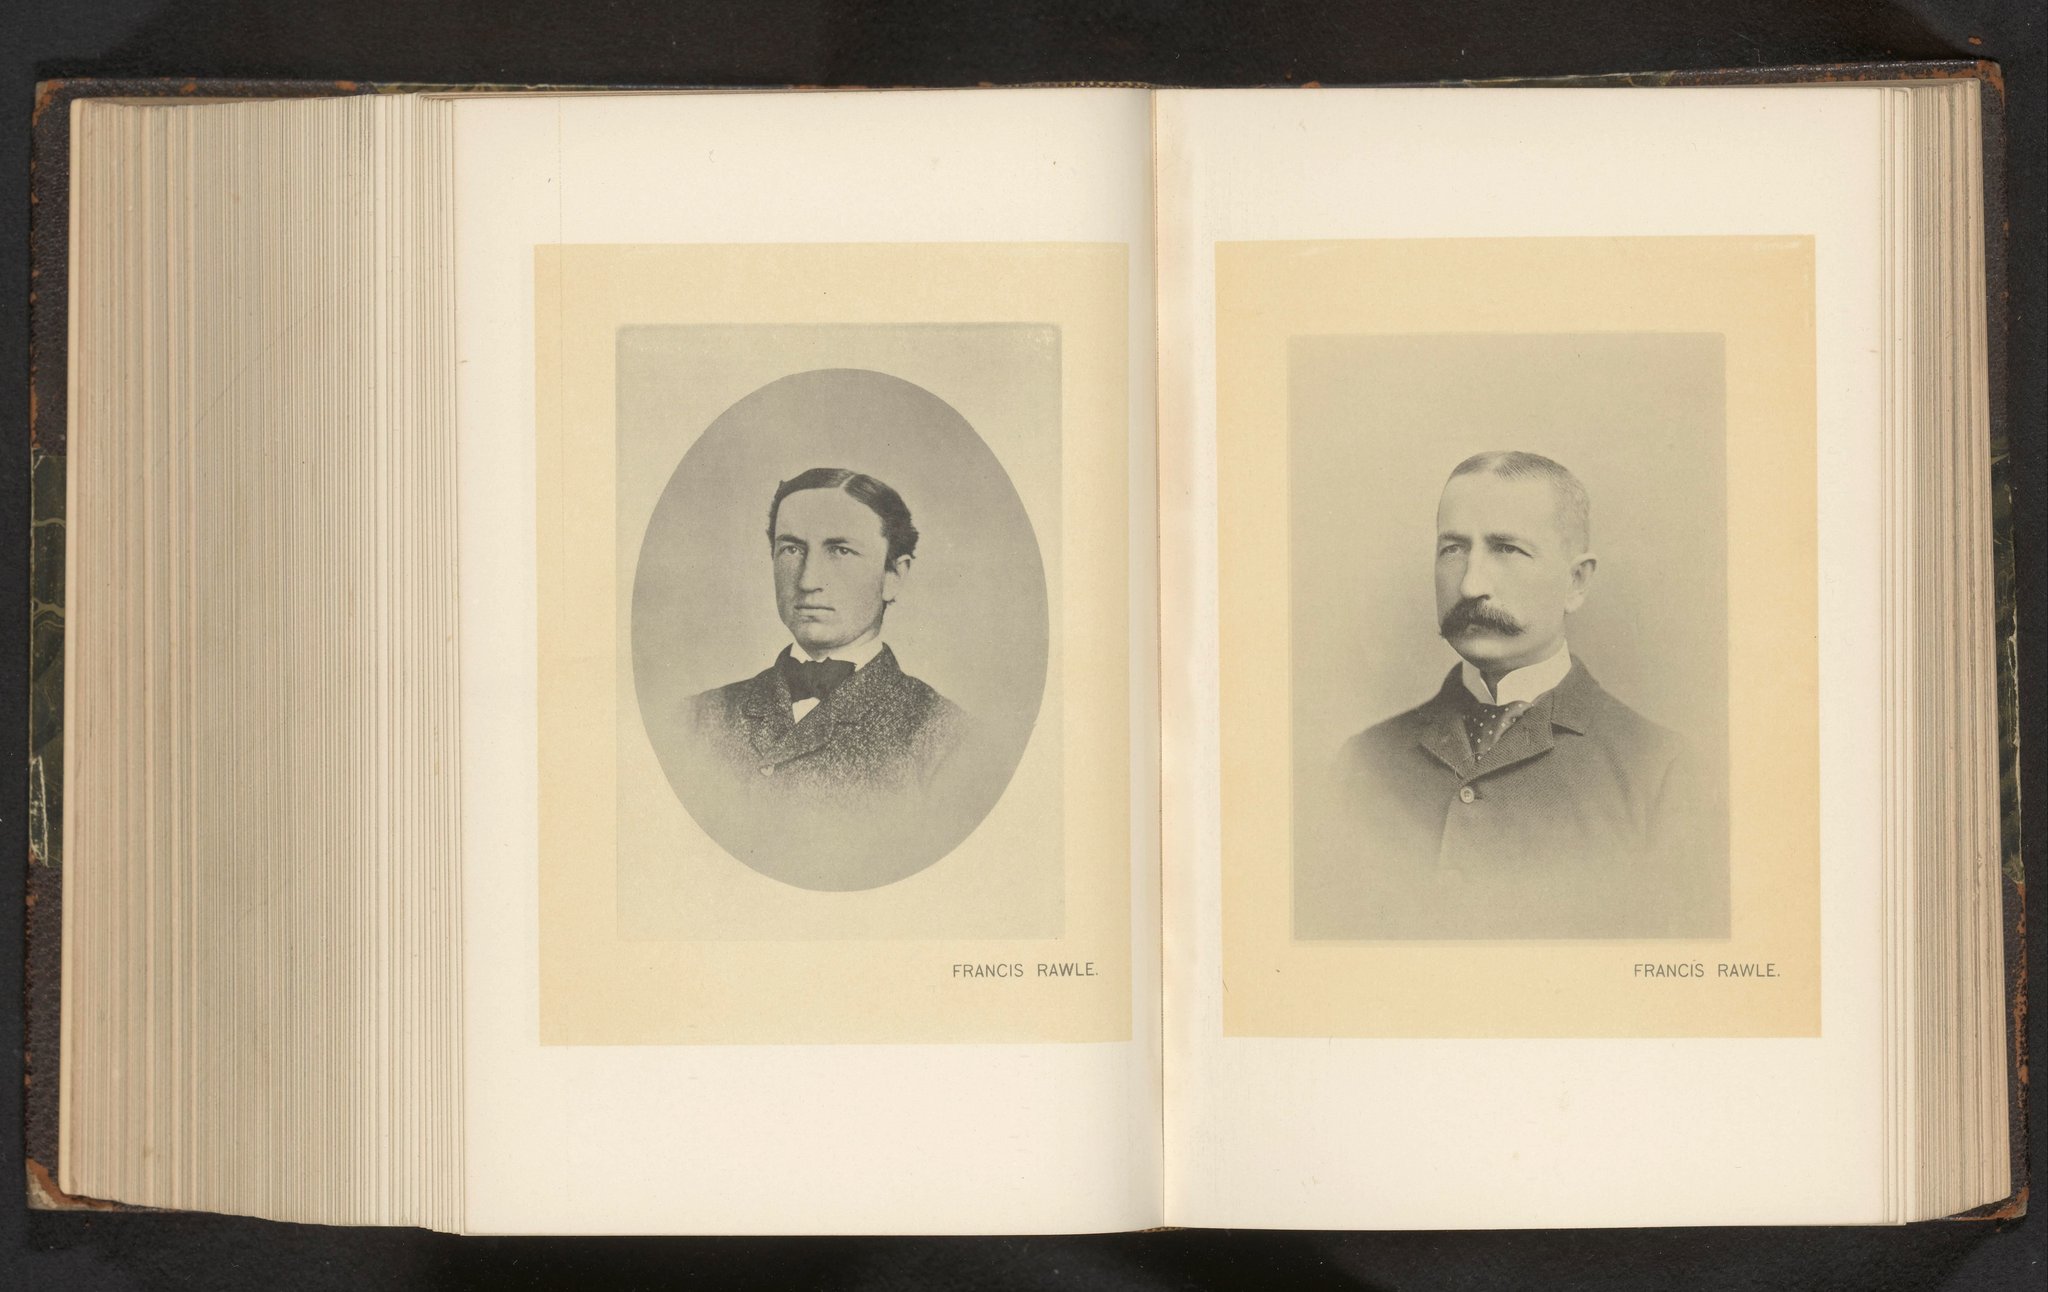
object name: page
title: Francis Rawle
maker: Anonymous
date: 1889-1894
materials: paper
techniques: photoaquatint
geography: boston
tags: adult man